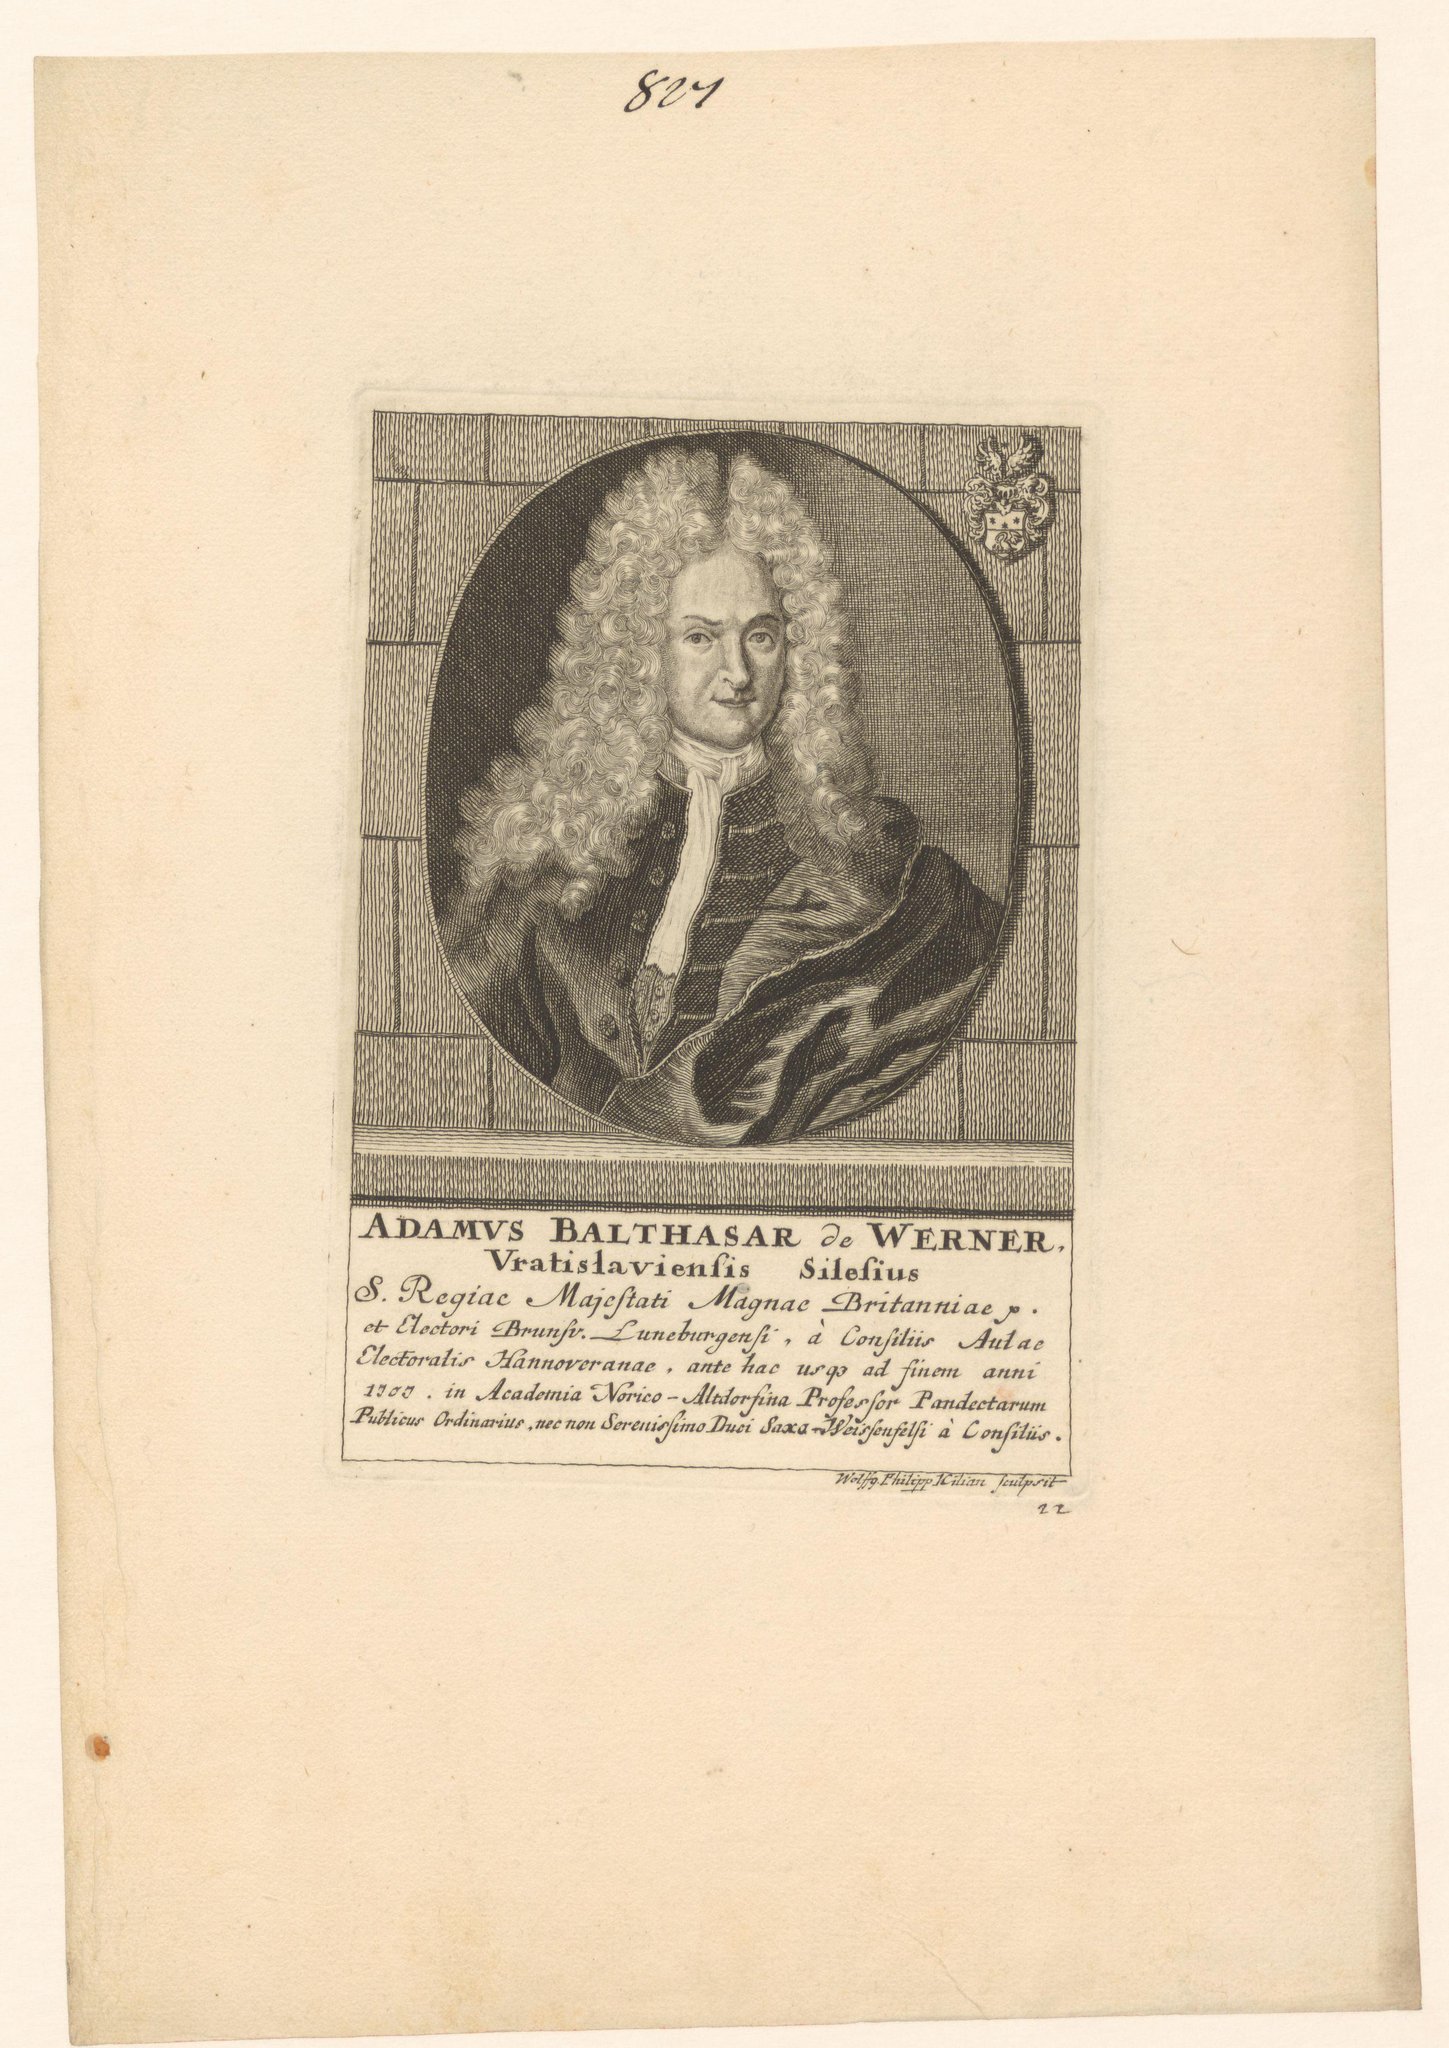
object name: print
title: Portret van Adam Balthasar von Werner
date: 1707-1732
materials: paper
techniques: engraving, etching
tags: further education (+ portrait of teacher, professor), historical persons, lawyer, attorney at law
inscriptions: number: ‘22’, collector's mark: Lugt 2228